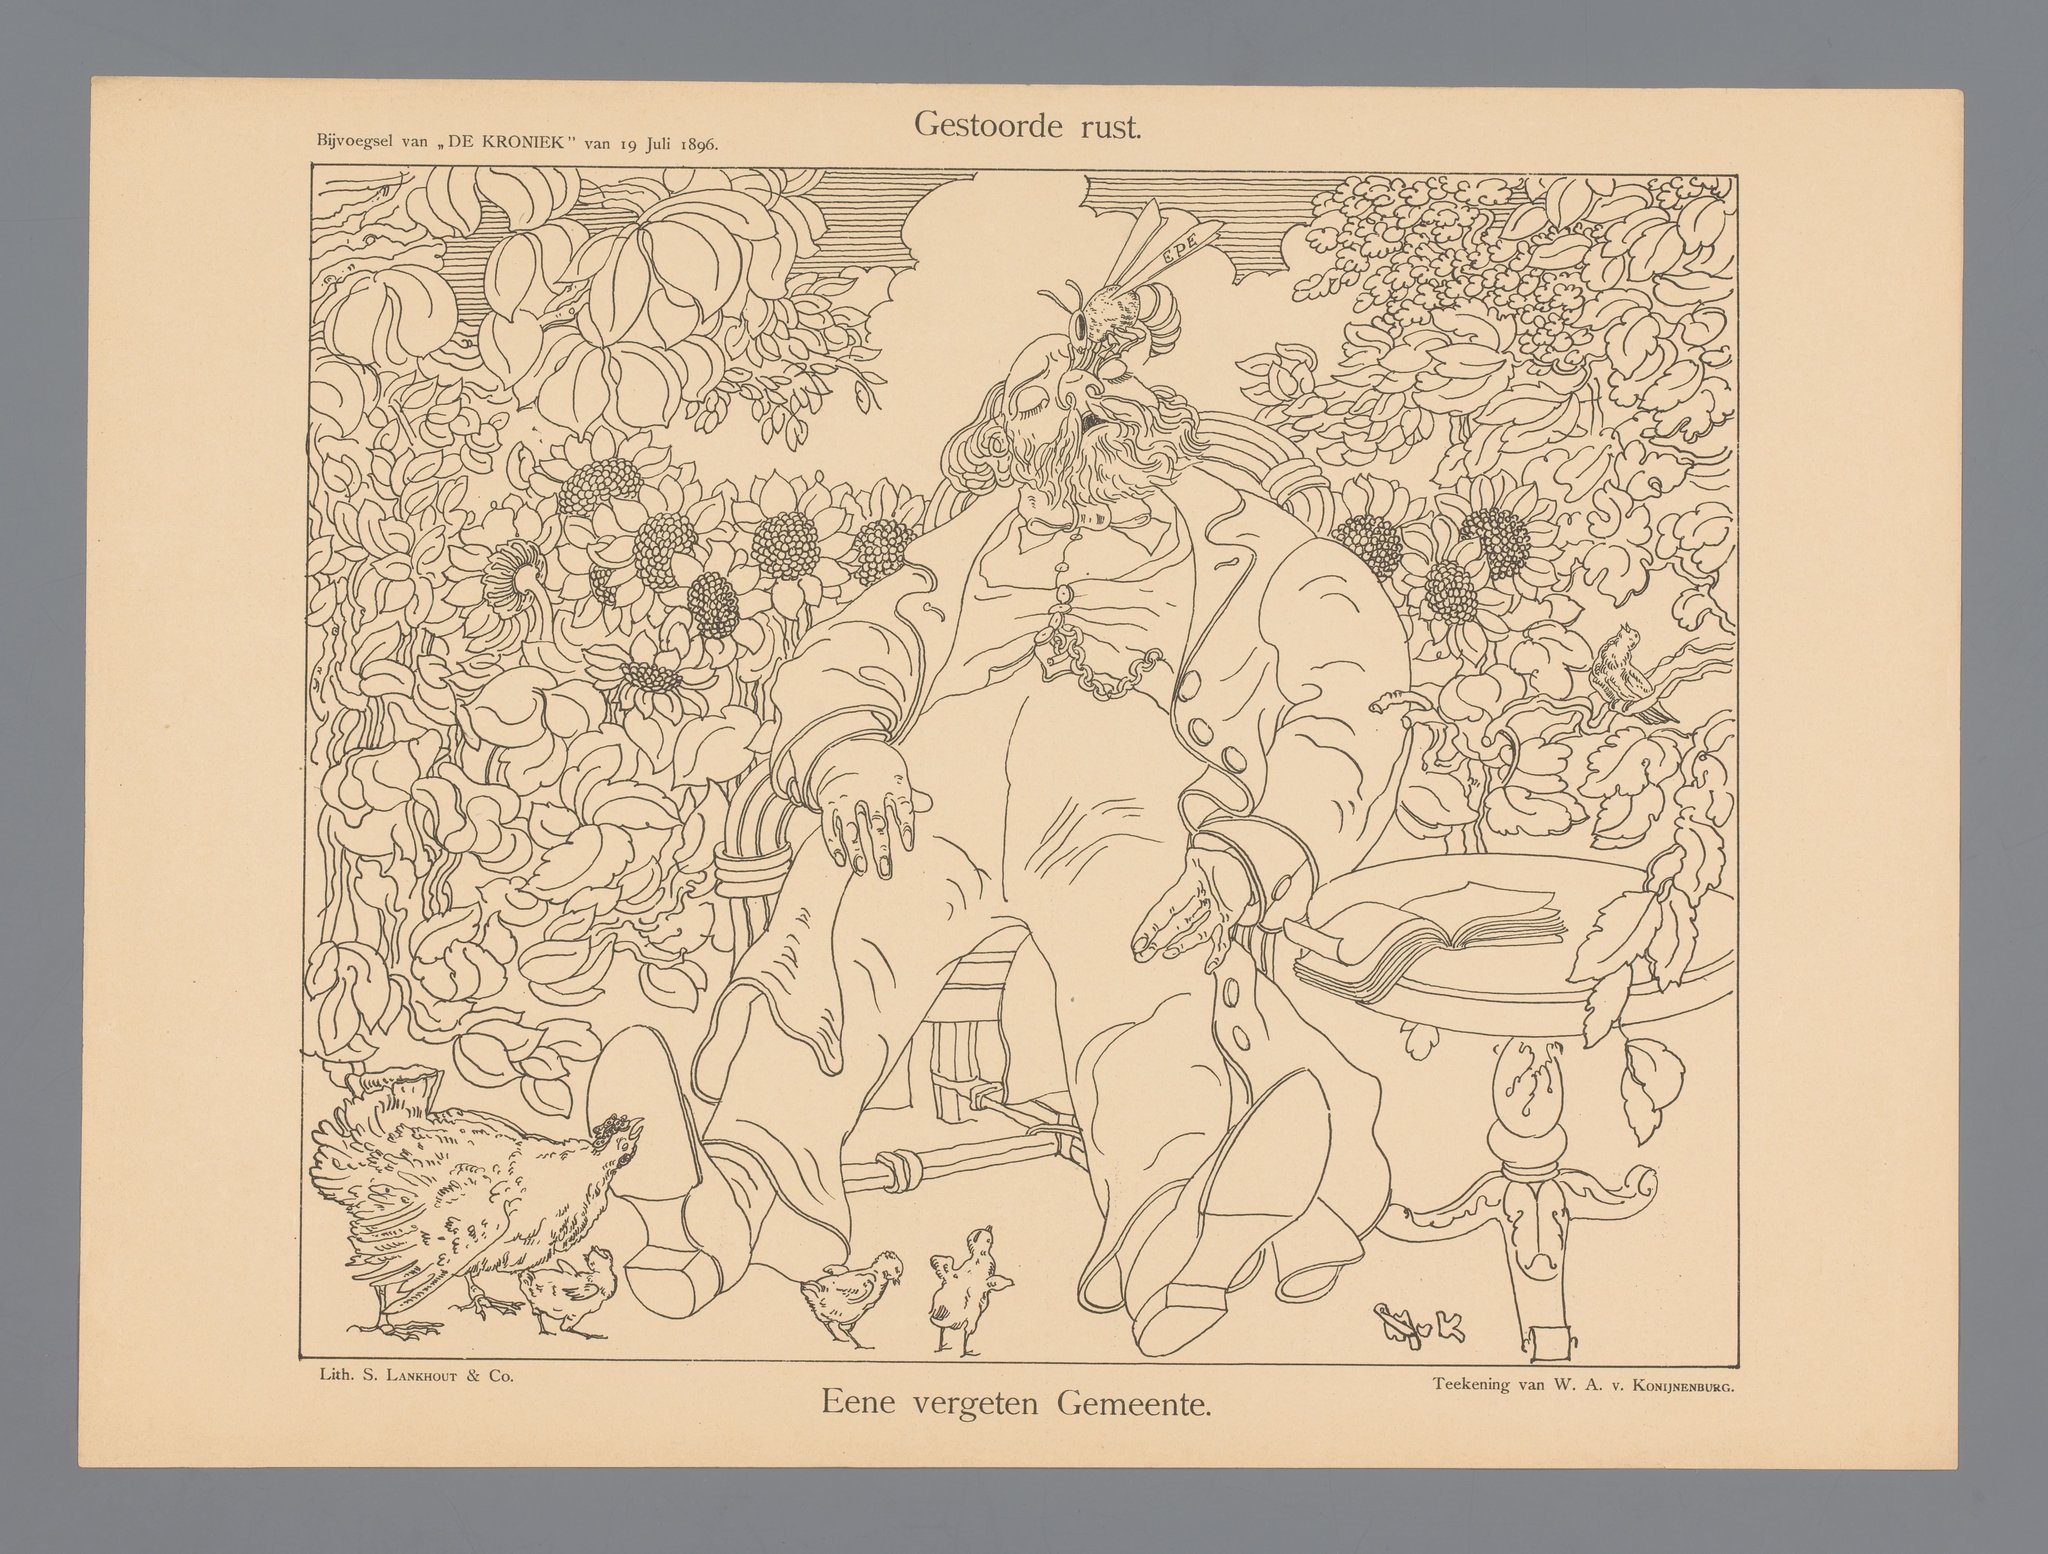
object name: cartoon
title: Gestoorde rust / Eene vergeten Gemeente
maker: willem van konijnenburg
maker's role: draughtsman, painter, print maker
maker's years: 1868-1943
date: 1896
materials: paper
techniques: lithograph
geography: the hague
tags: sleeping in chair - bb - out of doors, insects: wasp, political caricatures and satires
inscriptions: date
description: Prent uit het bijvoegsel van: De Kroniek 2 (1896), 19 juli 1896.